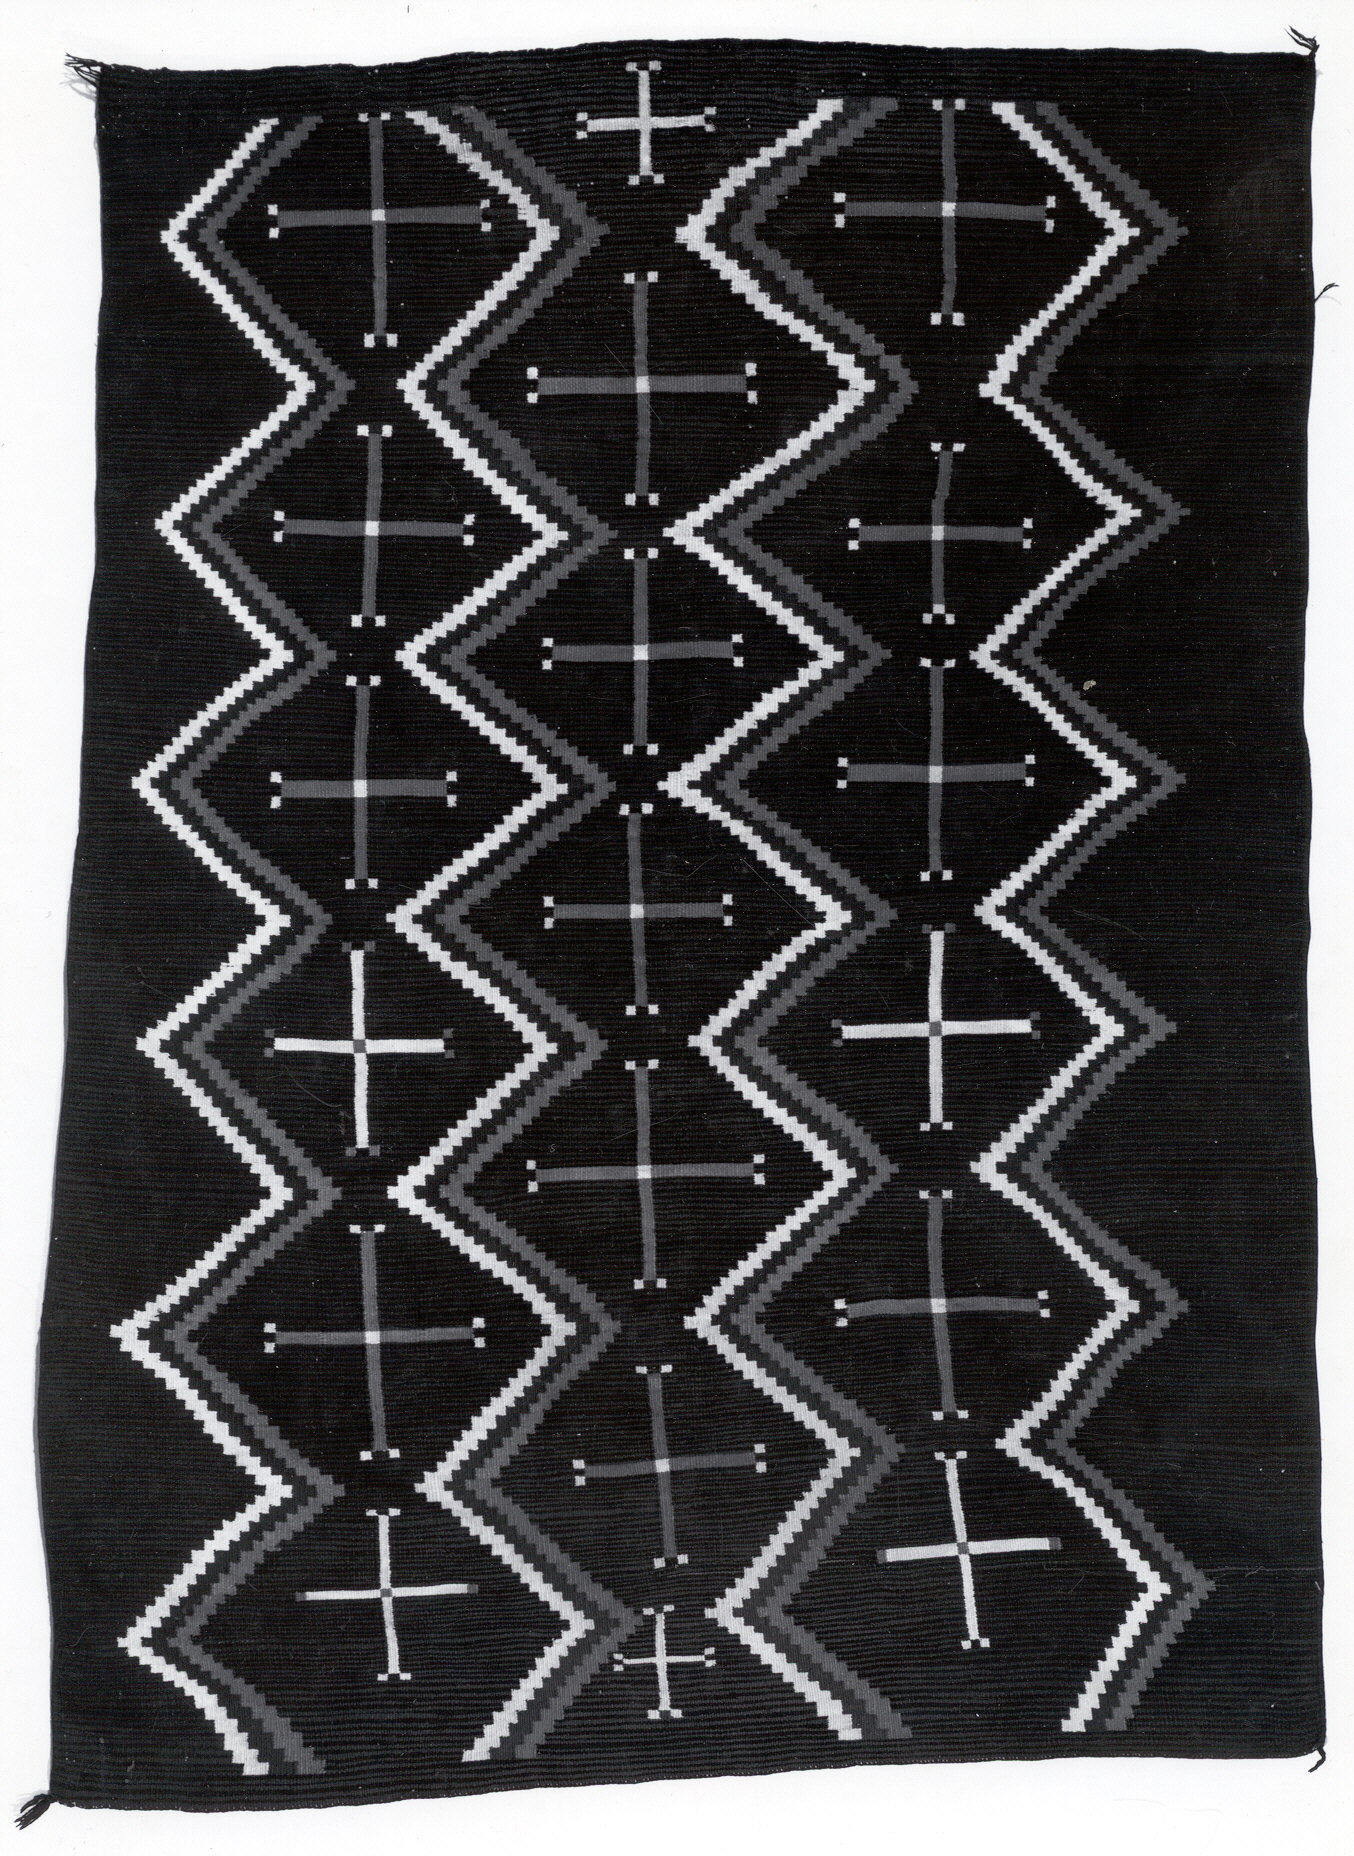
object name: blanket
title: Wearing Blanket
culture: navajo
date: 1870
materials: wool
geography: united states